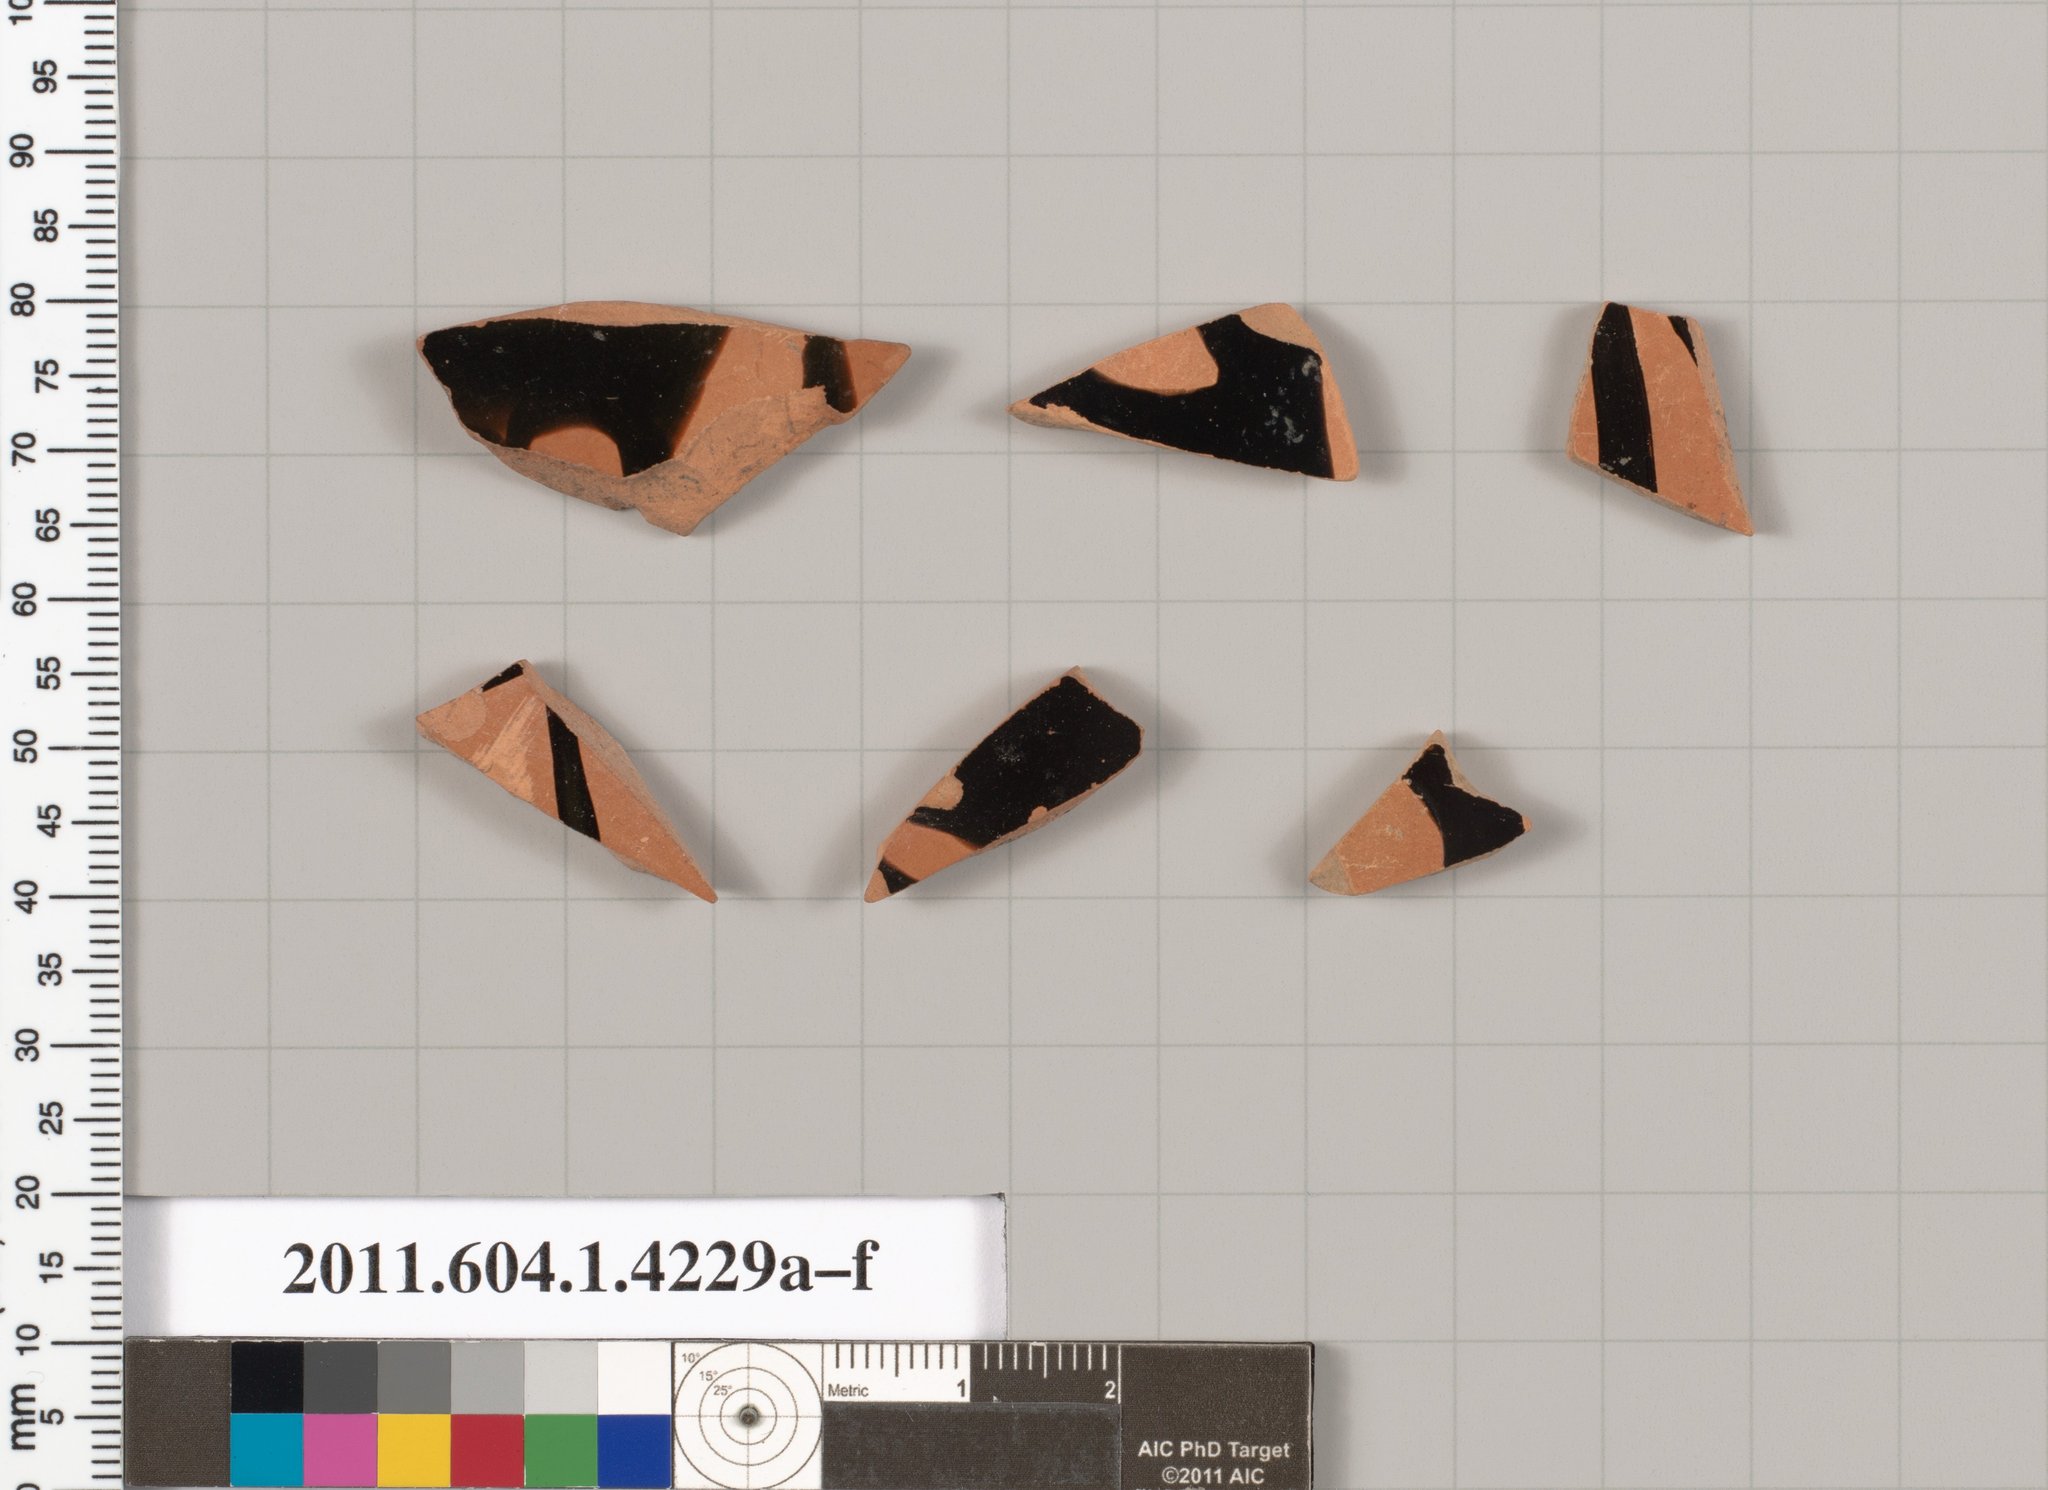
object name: kylix fragment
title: Terracotta fragments of kylikes (drinking cups)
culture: greek, attic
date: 500-451 BCE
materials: terracotta